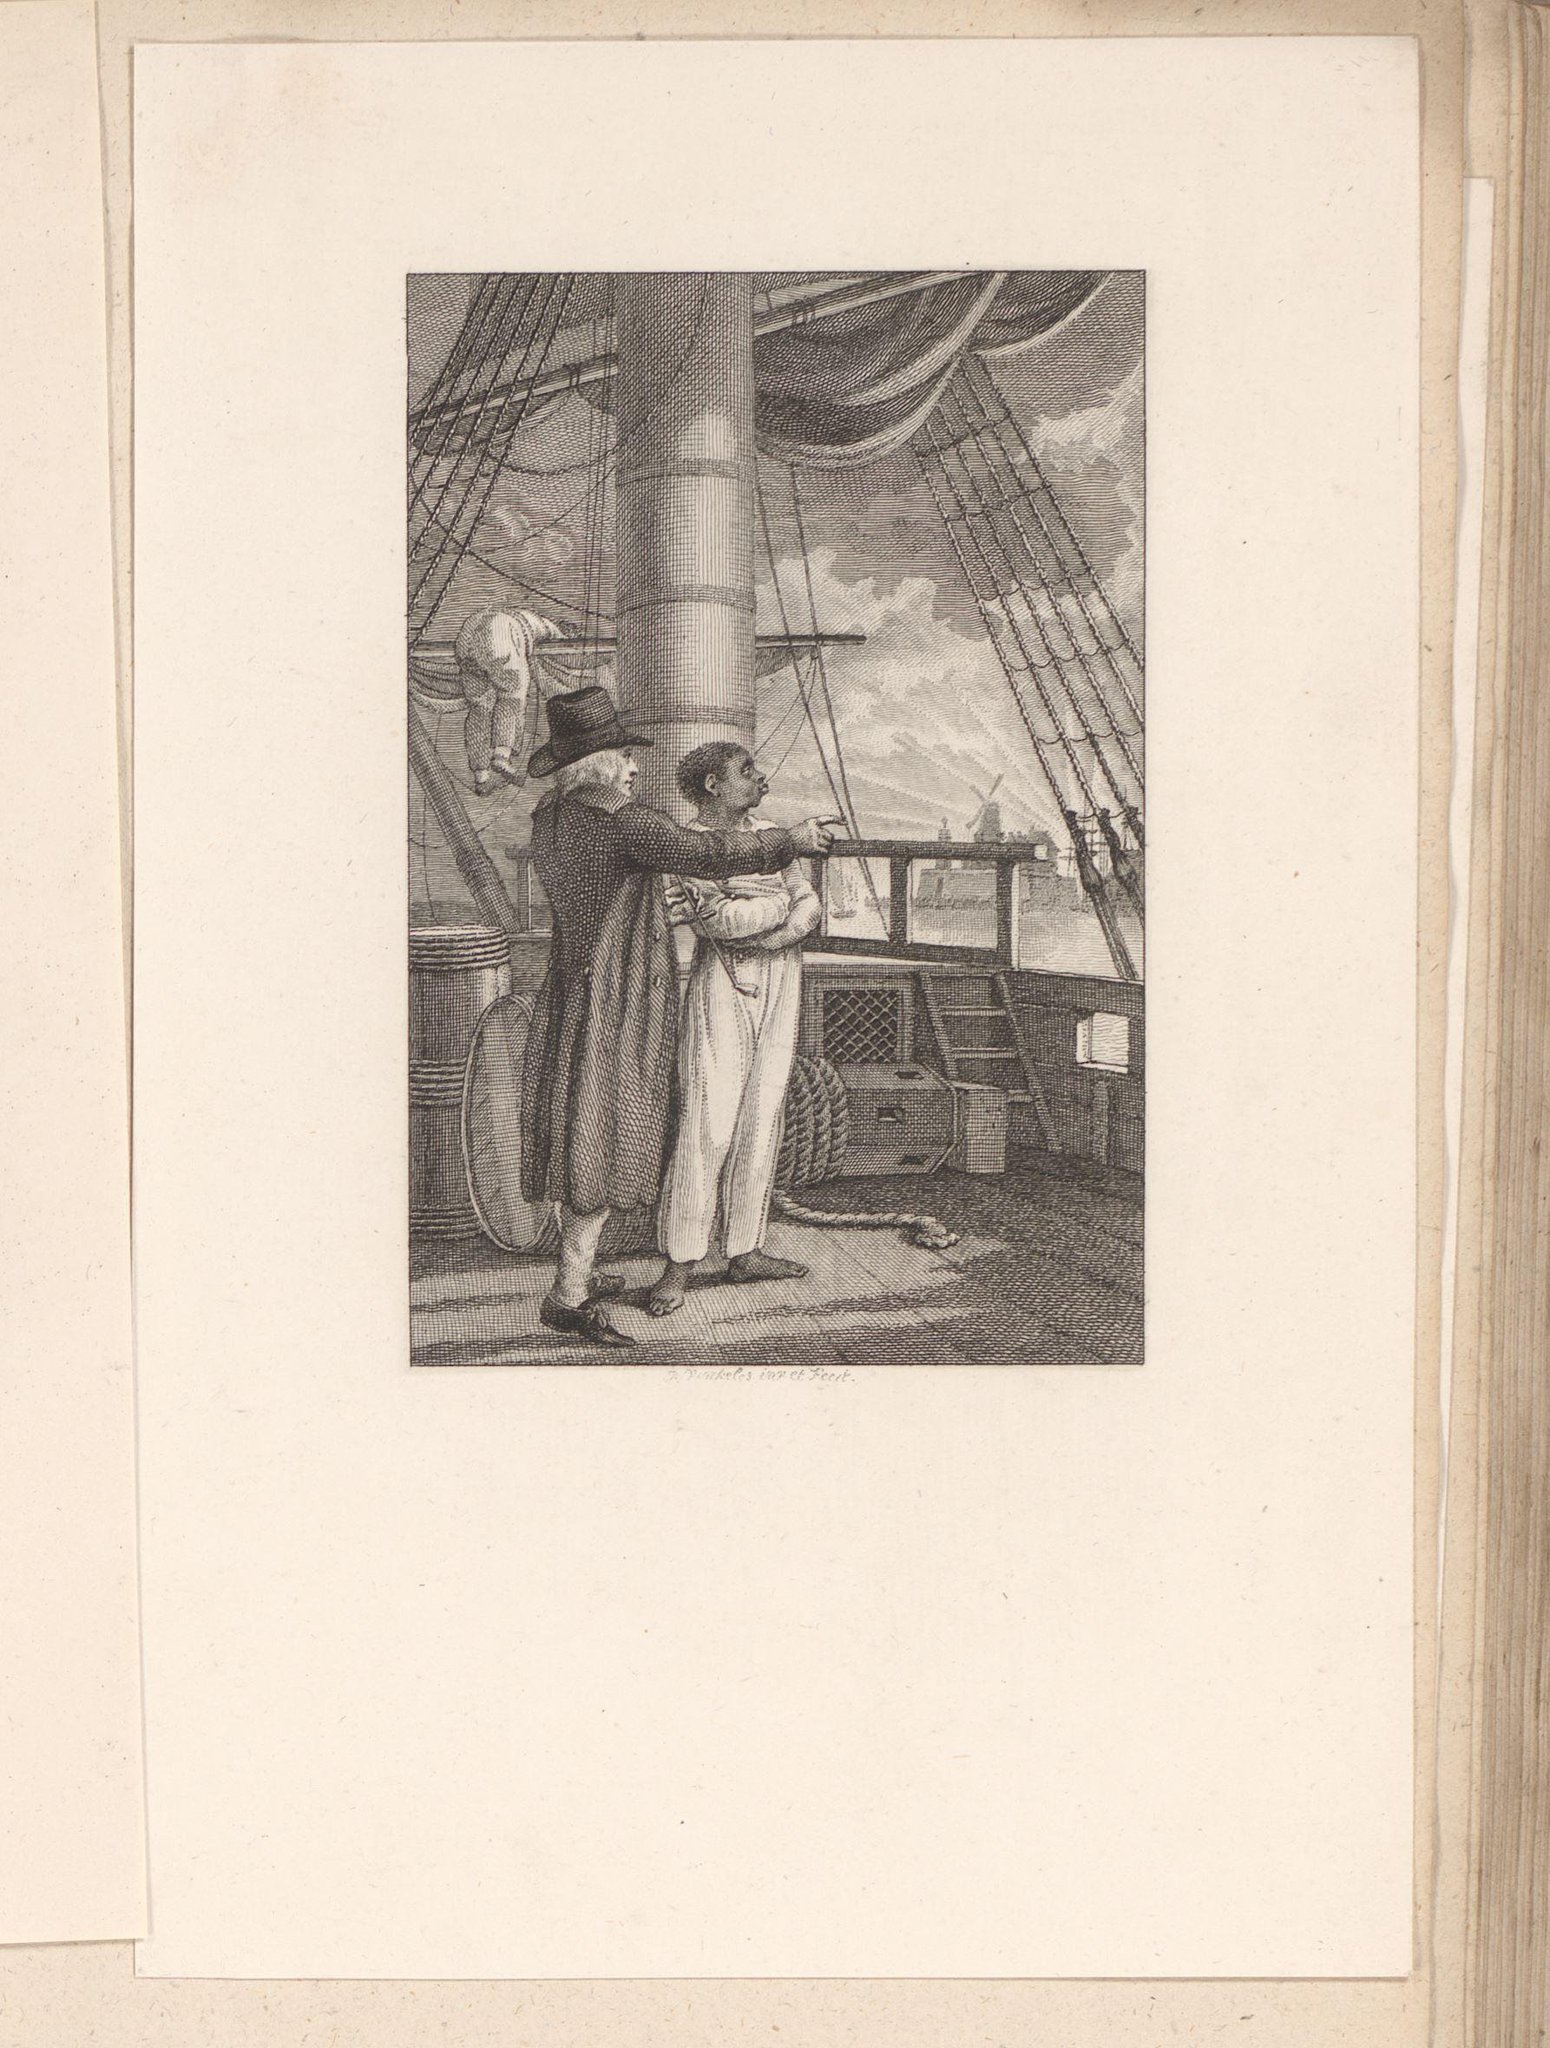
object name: book illustration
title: Marines van Ierseke laat een Afrikaanse man vanaf een boot Vlissingen zien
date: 1804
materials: paper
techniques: engraving, etching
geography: haarlem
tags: sailing-ship, sailing-boat, africans, pipe ~ tobacco, index finger forwards, pointing, indicating, flushing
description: Proefdruk van een boekillustratie gebruikt in: Loosjes, Adriaan Pietersz. Zedelijke Verhaalen. Haarlem: Adriaan Loosjes, 1804-1805. Tweede druk Haarlem: Adriaan Loosjes, 1815.